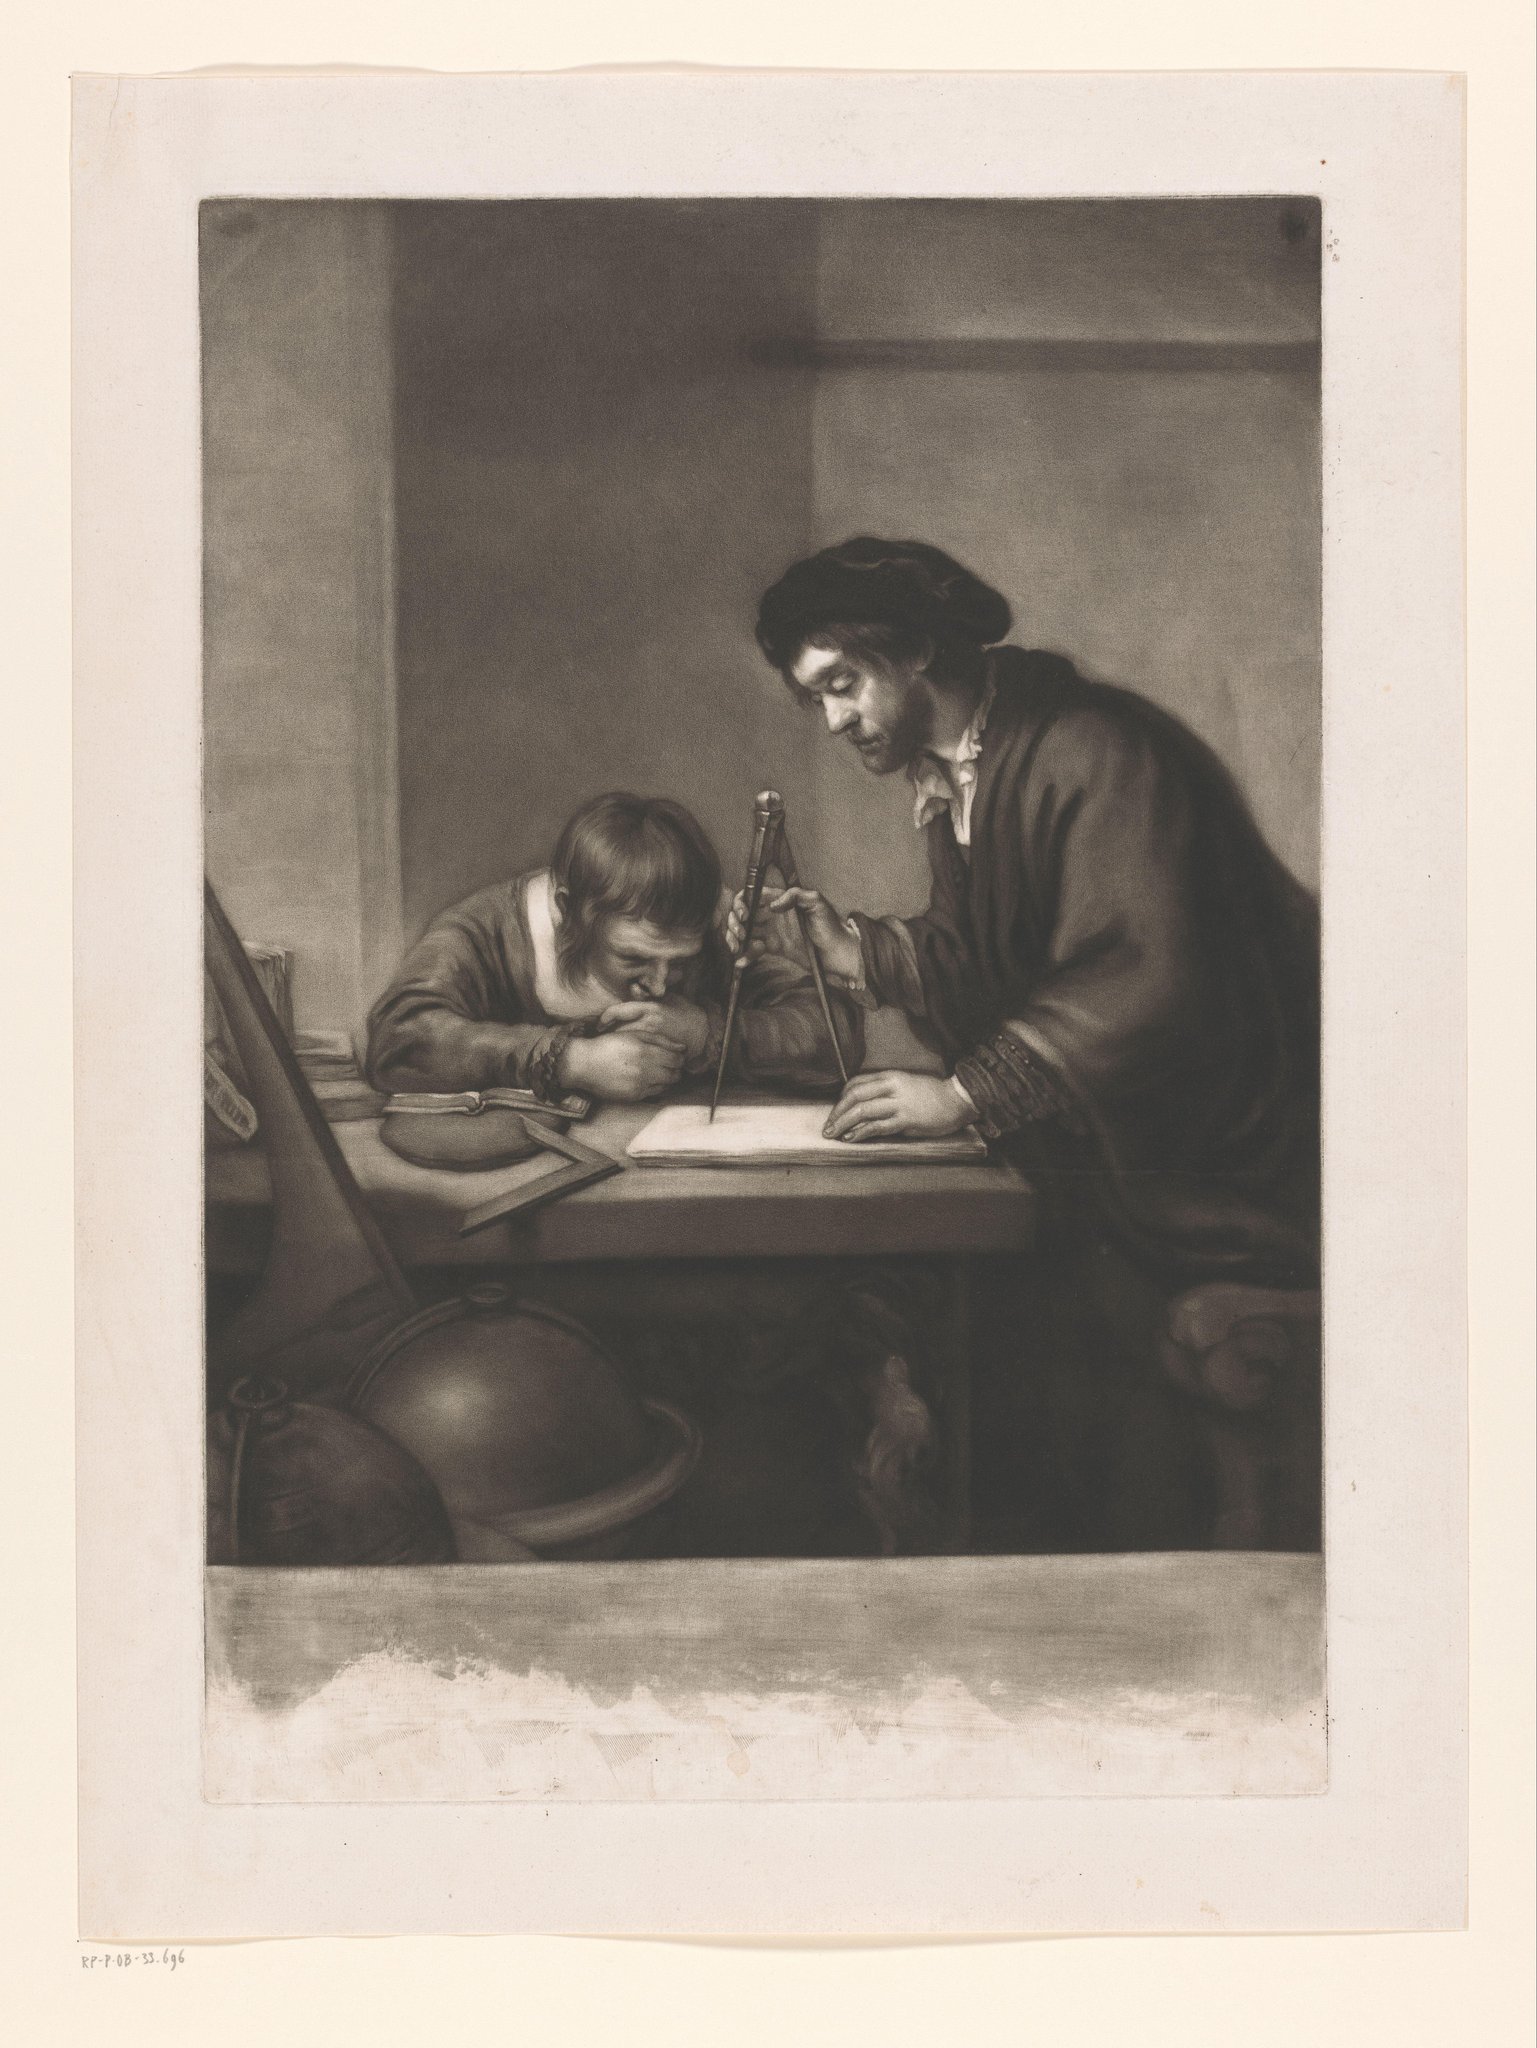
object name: print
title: Staande man met passer en jongen zittend aan een tafel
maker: james mcardell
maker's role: print maker, publisher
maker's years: 1728-1765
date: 1745-1765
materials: paper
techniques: mezzotint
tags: compasses, teacher and pupil, mathematics (+ scholar, scientist (at work)), globe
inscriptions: collector's mark: Lugt 240